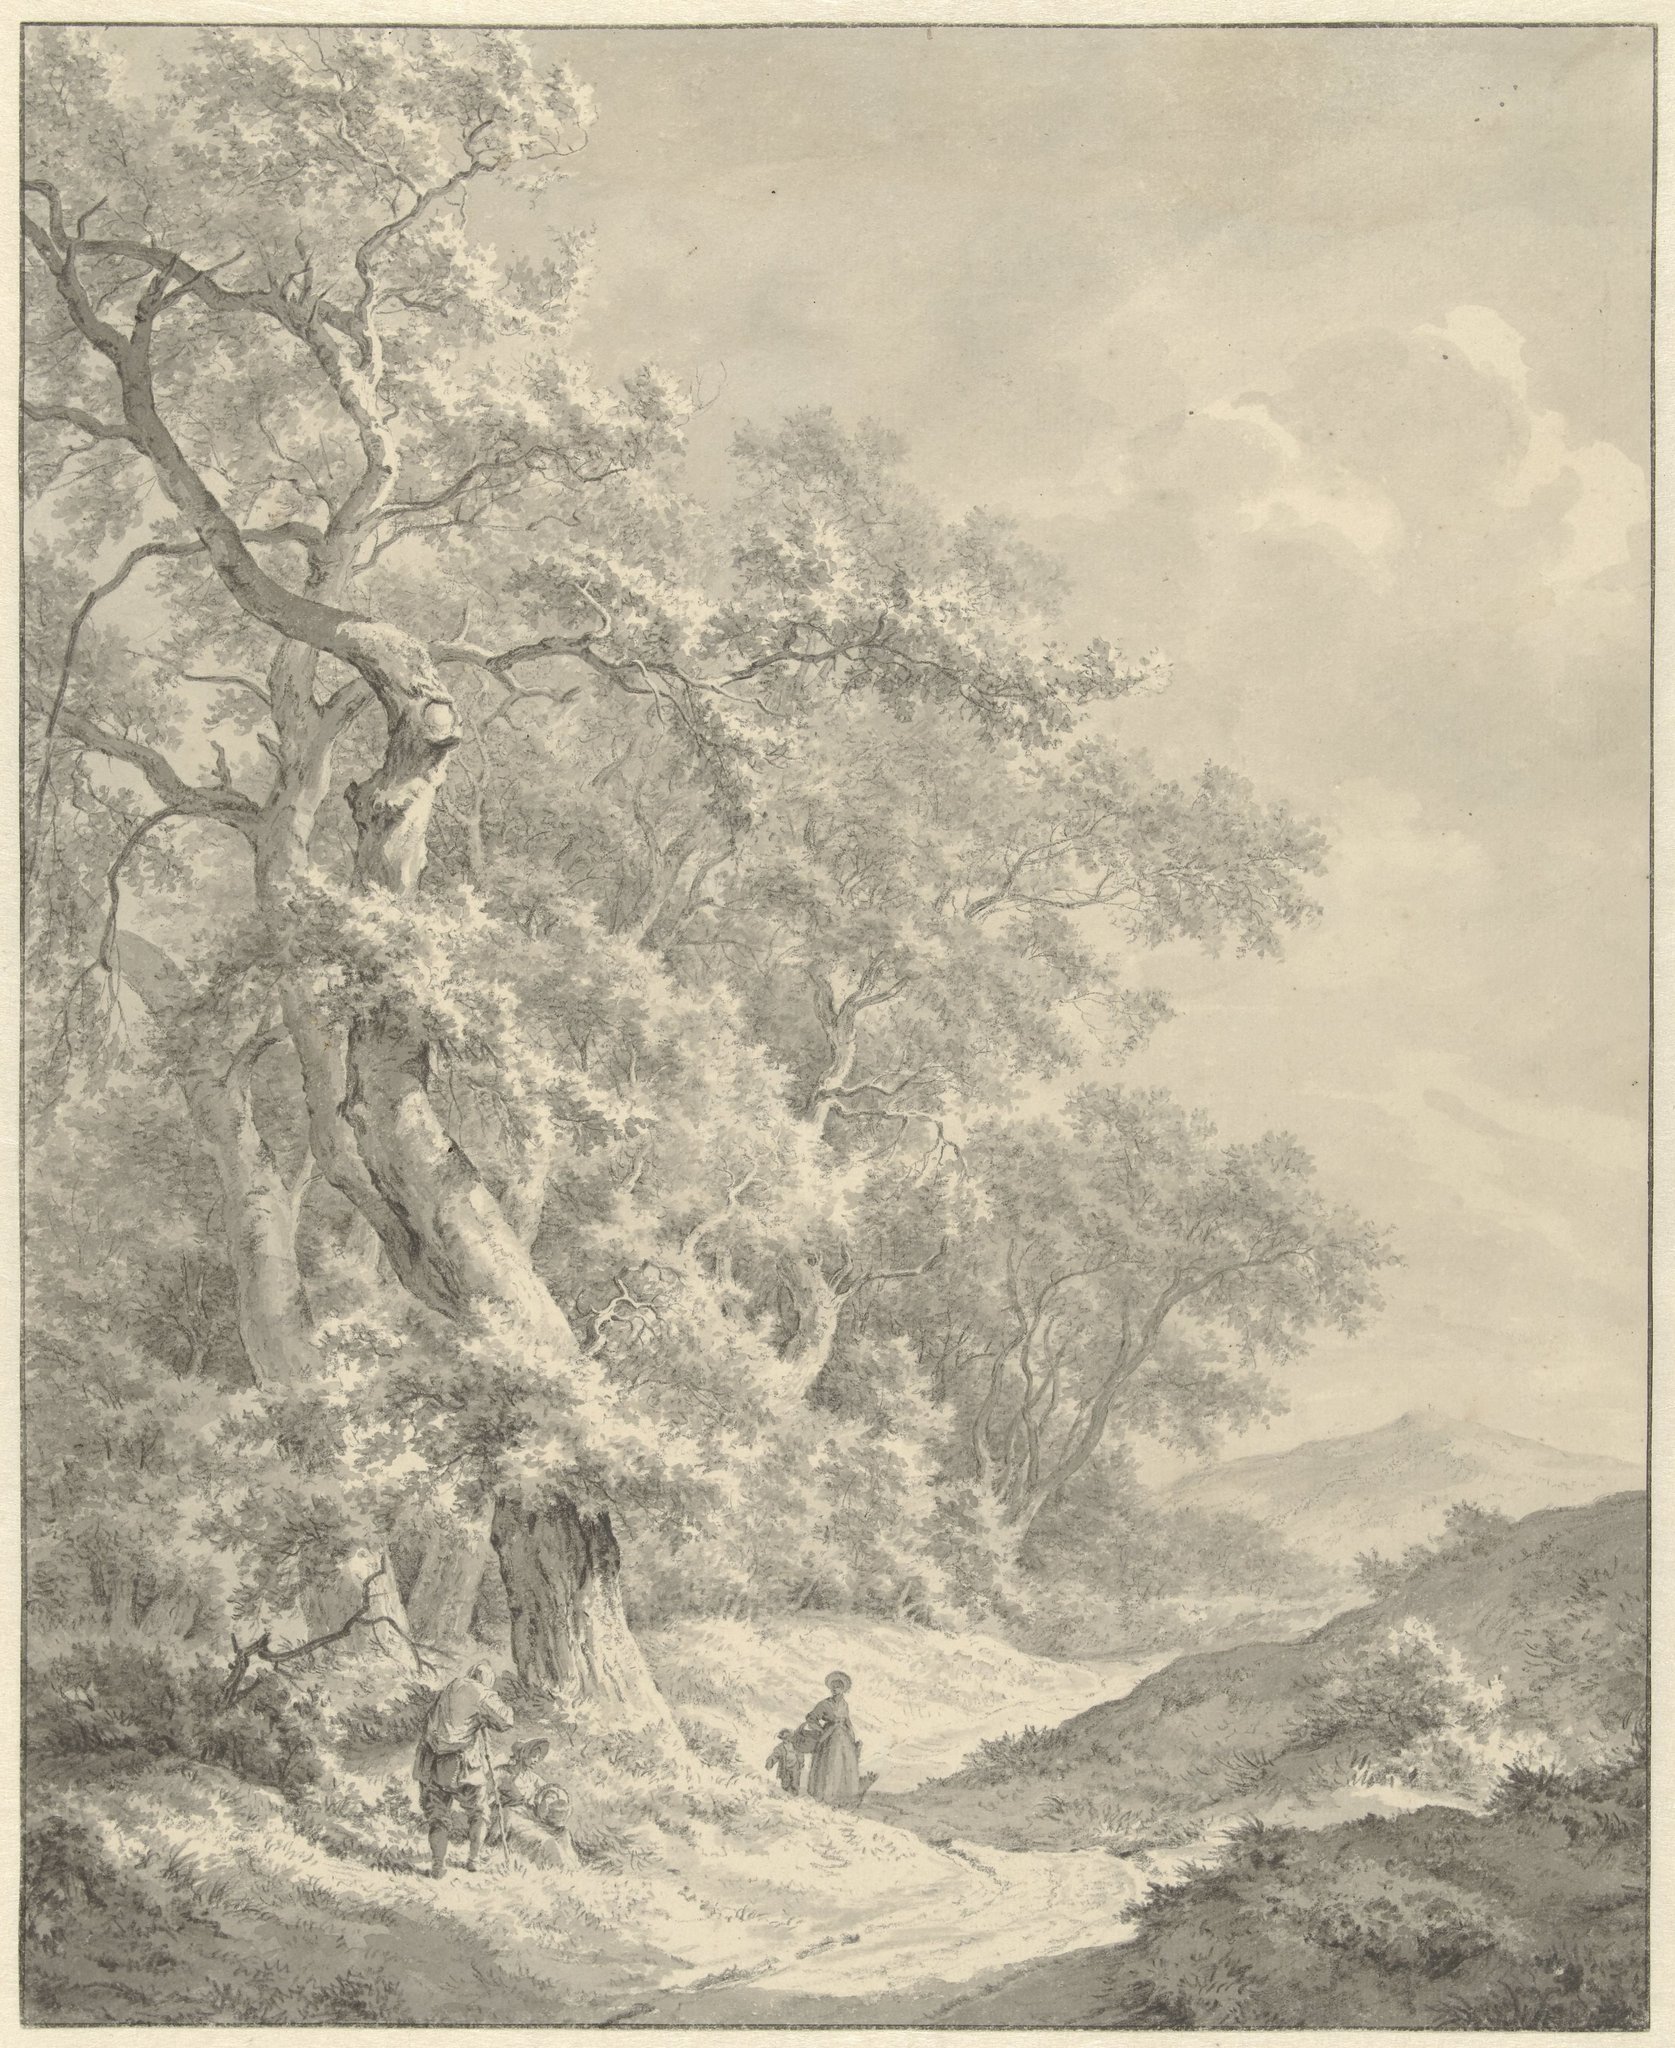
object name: drawing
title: Landschap met wandelaars op pad langs bos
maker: franciscus andreas milatz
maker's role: draughtsman, painter, print maker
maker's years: 1764-1808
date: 1774-1808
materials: chalk, paper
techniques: brush